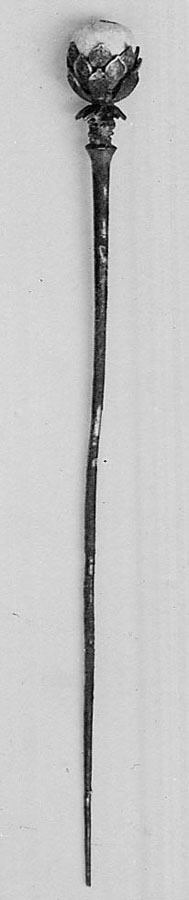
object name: hairpin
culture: chinese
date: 1368-1644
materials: silver gilt, pearl